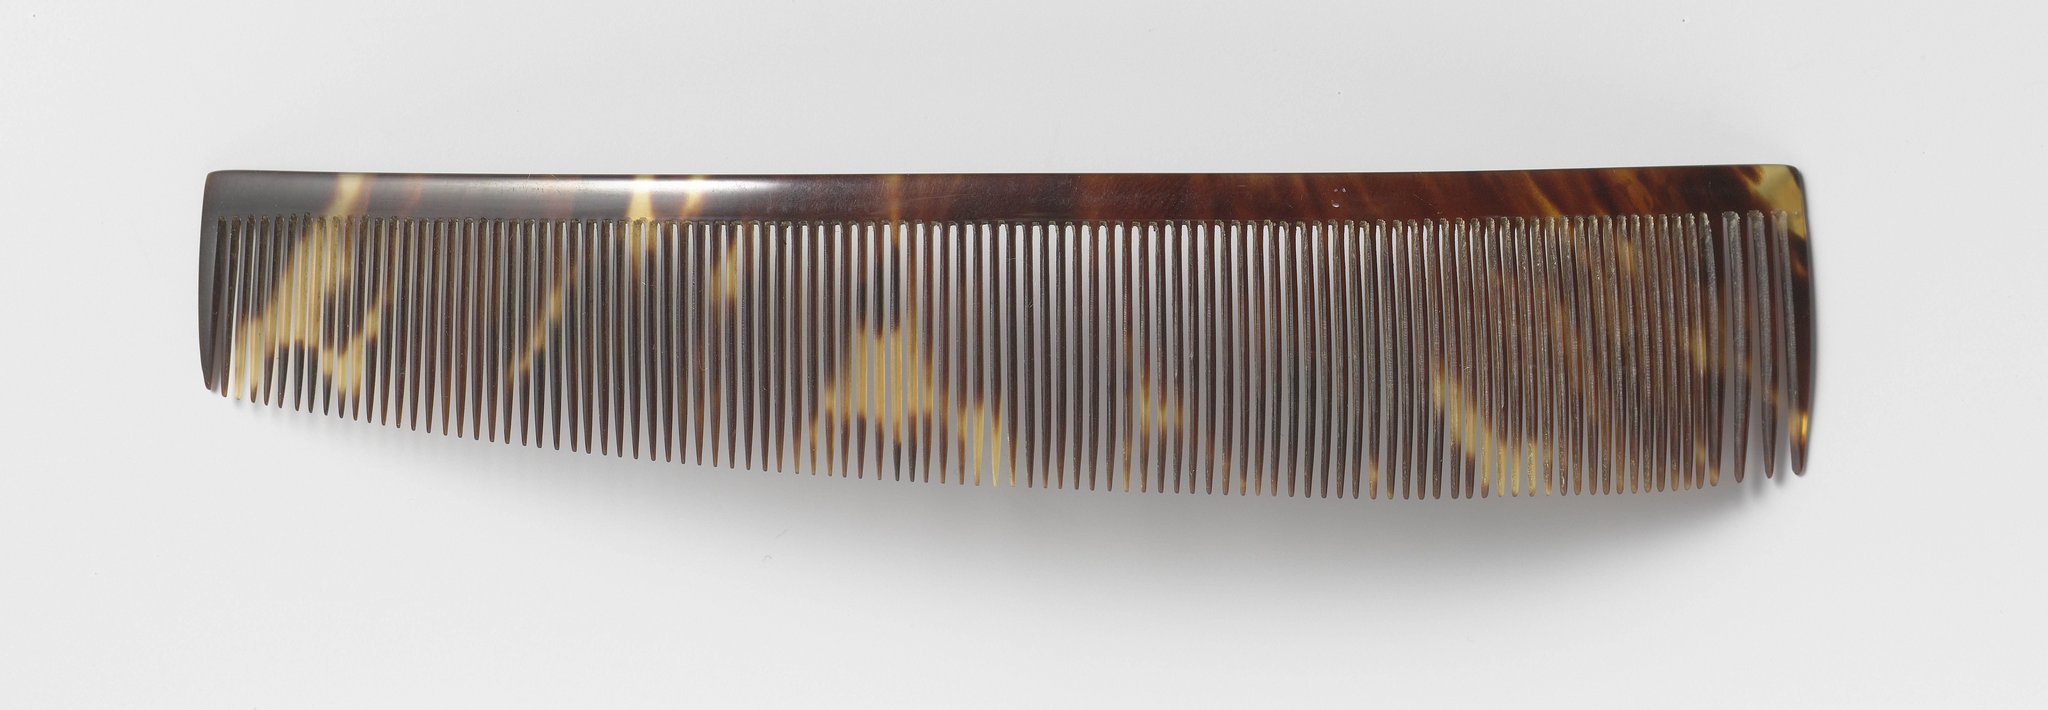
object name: comb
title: Haarkam of kam van imitatie schildpad, met een lange rij smalle tanden, taps aflopend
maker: Anonymous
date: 1800-1899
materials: celluloid, plastic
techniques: cutting, polish, pressing, sawing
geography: netherlands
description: Haarkam of kam van imitatie schildpad, met een lange rij smalle tanden, taps aflopend.